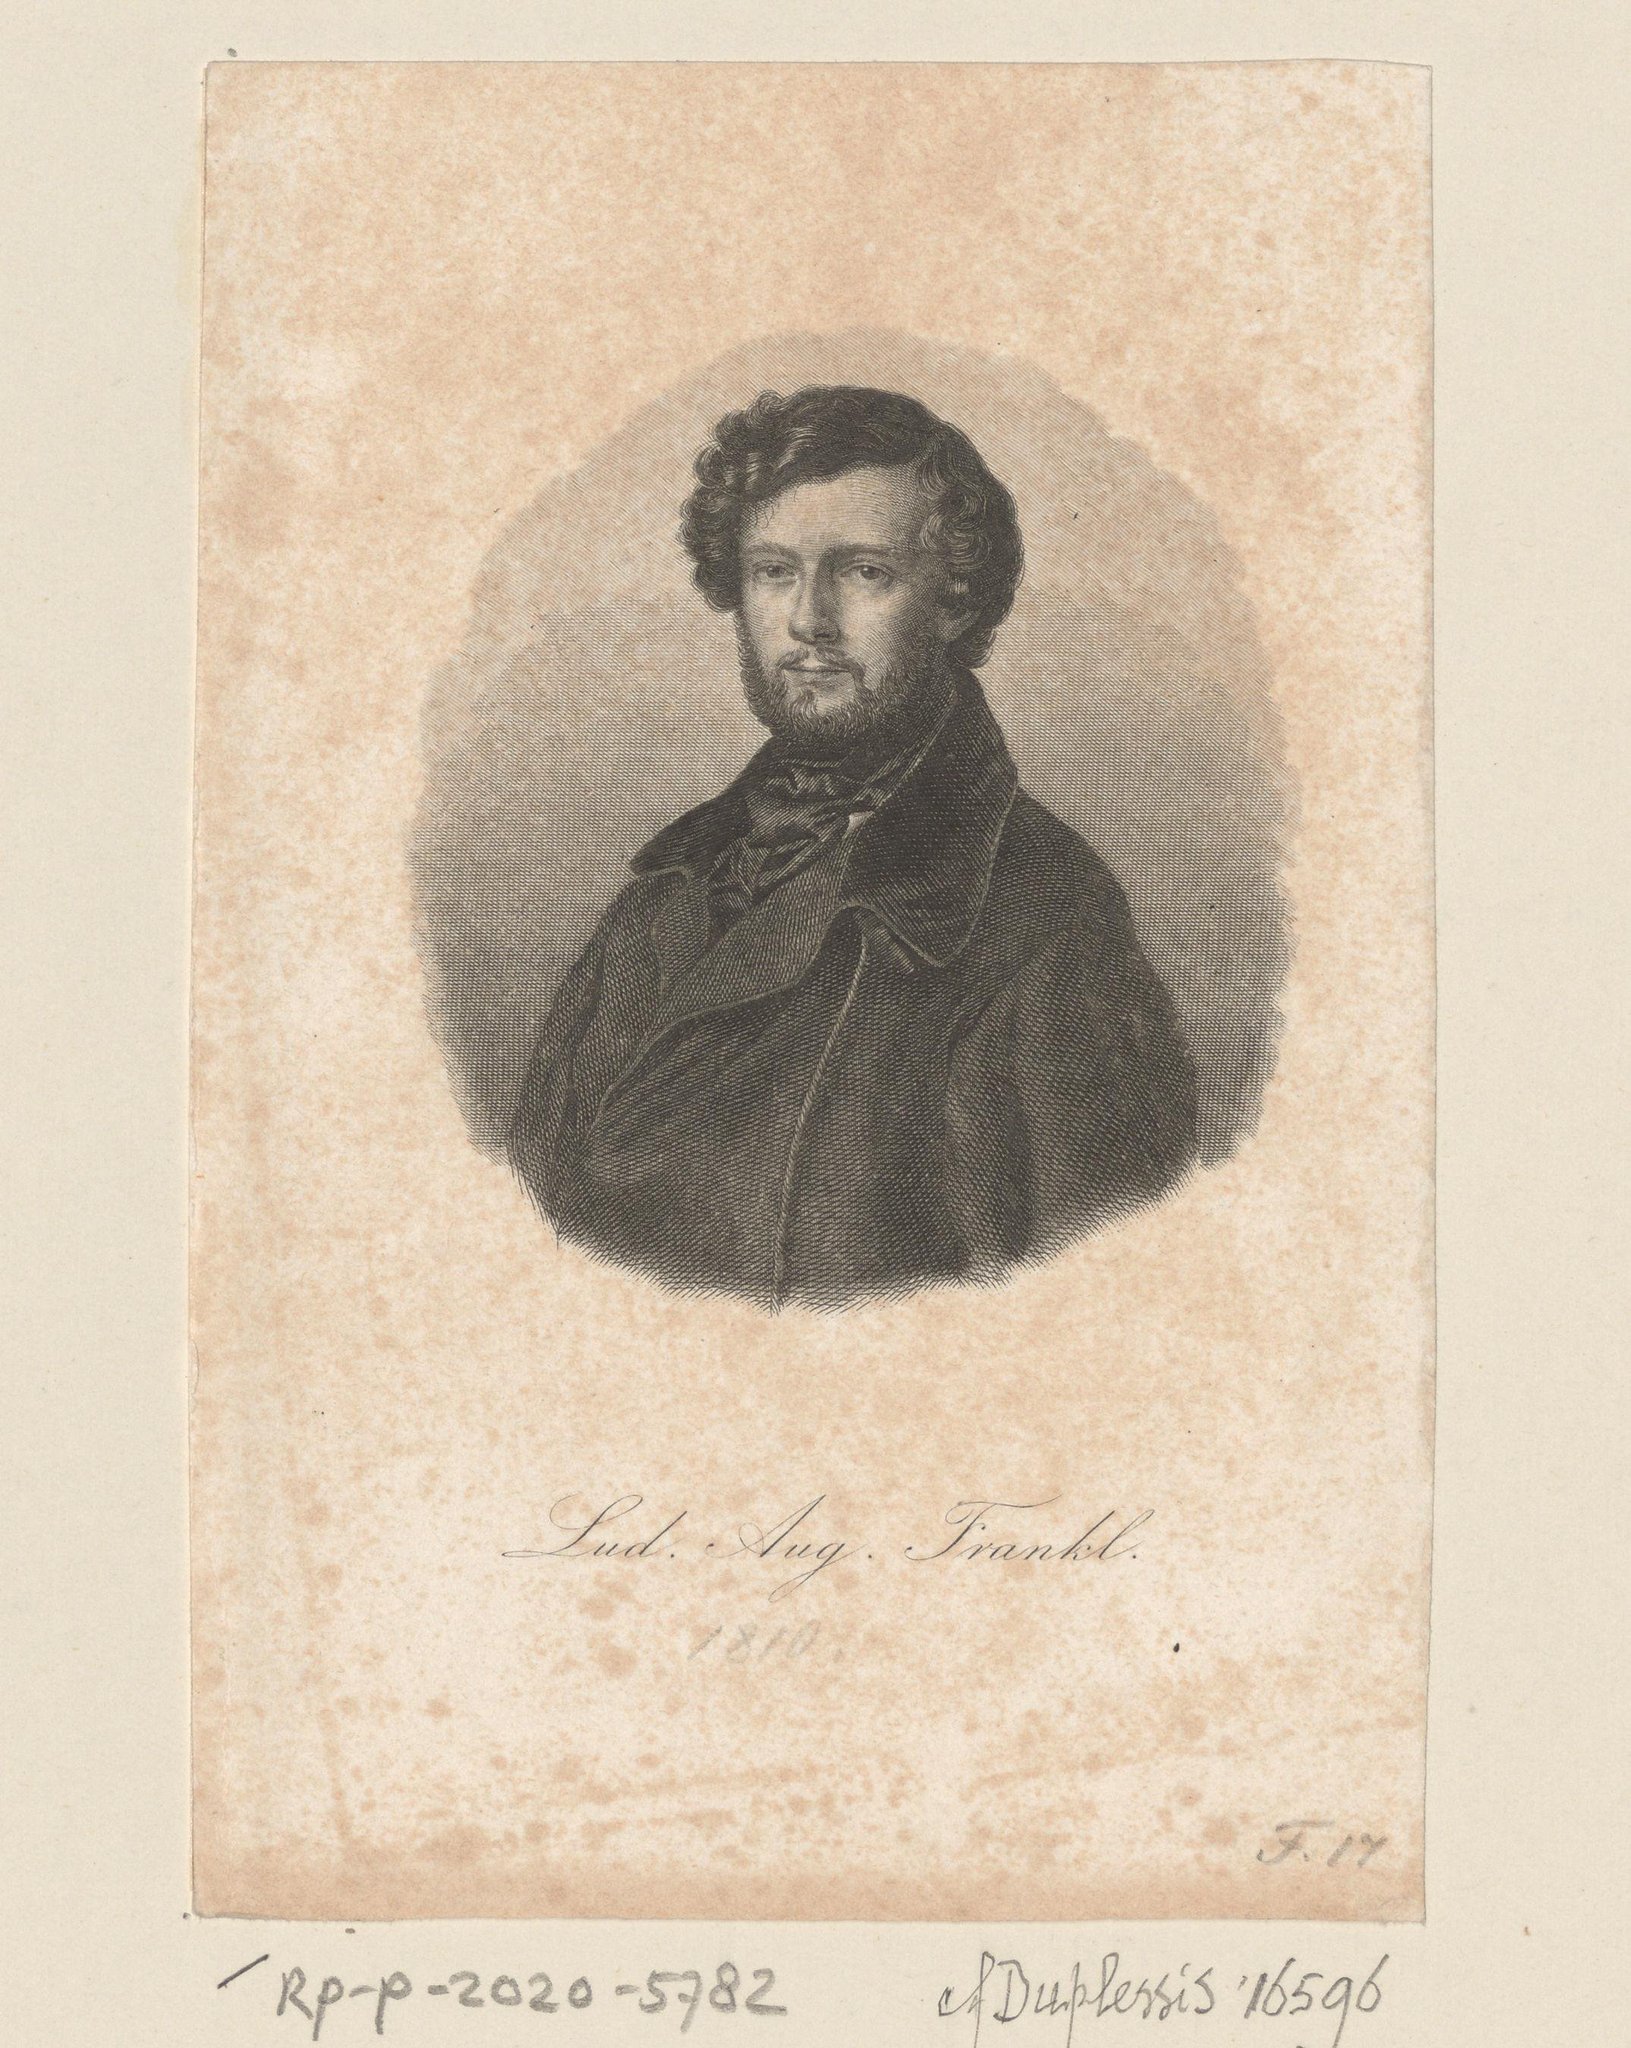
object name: print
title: Portret van Ludwig August von Frankl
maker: Anonymous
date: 1835-1880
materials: paper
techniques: engraving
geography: germany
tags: publisher, historical persons, portrait of a writer